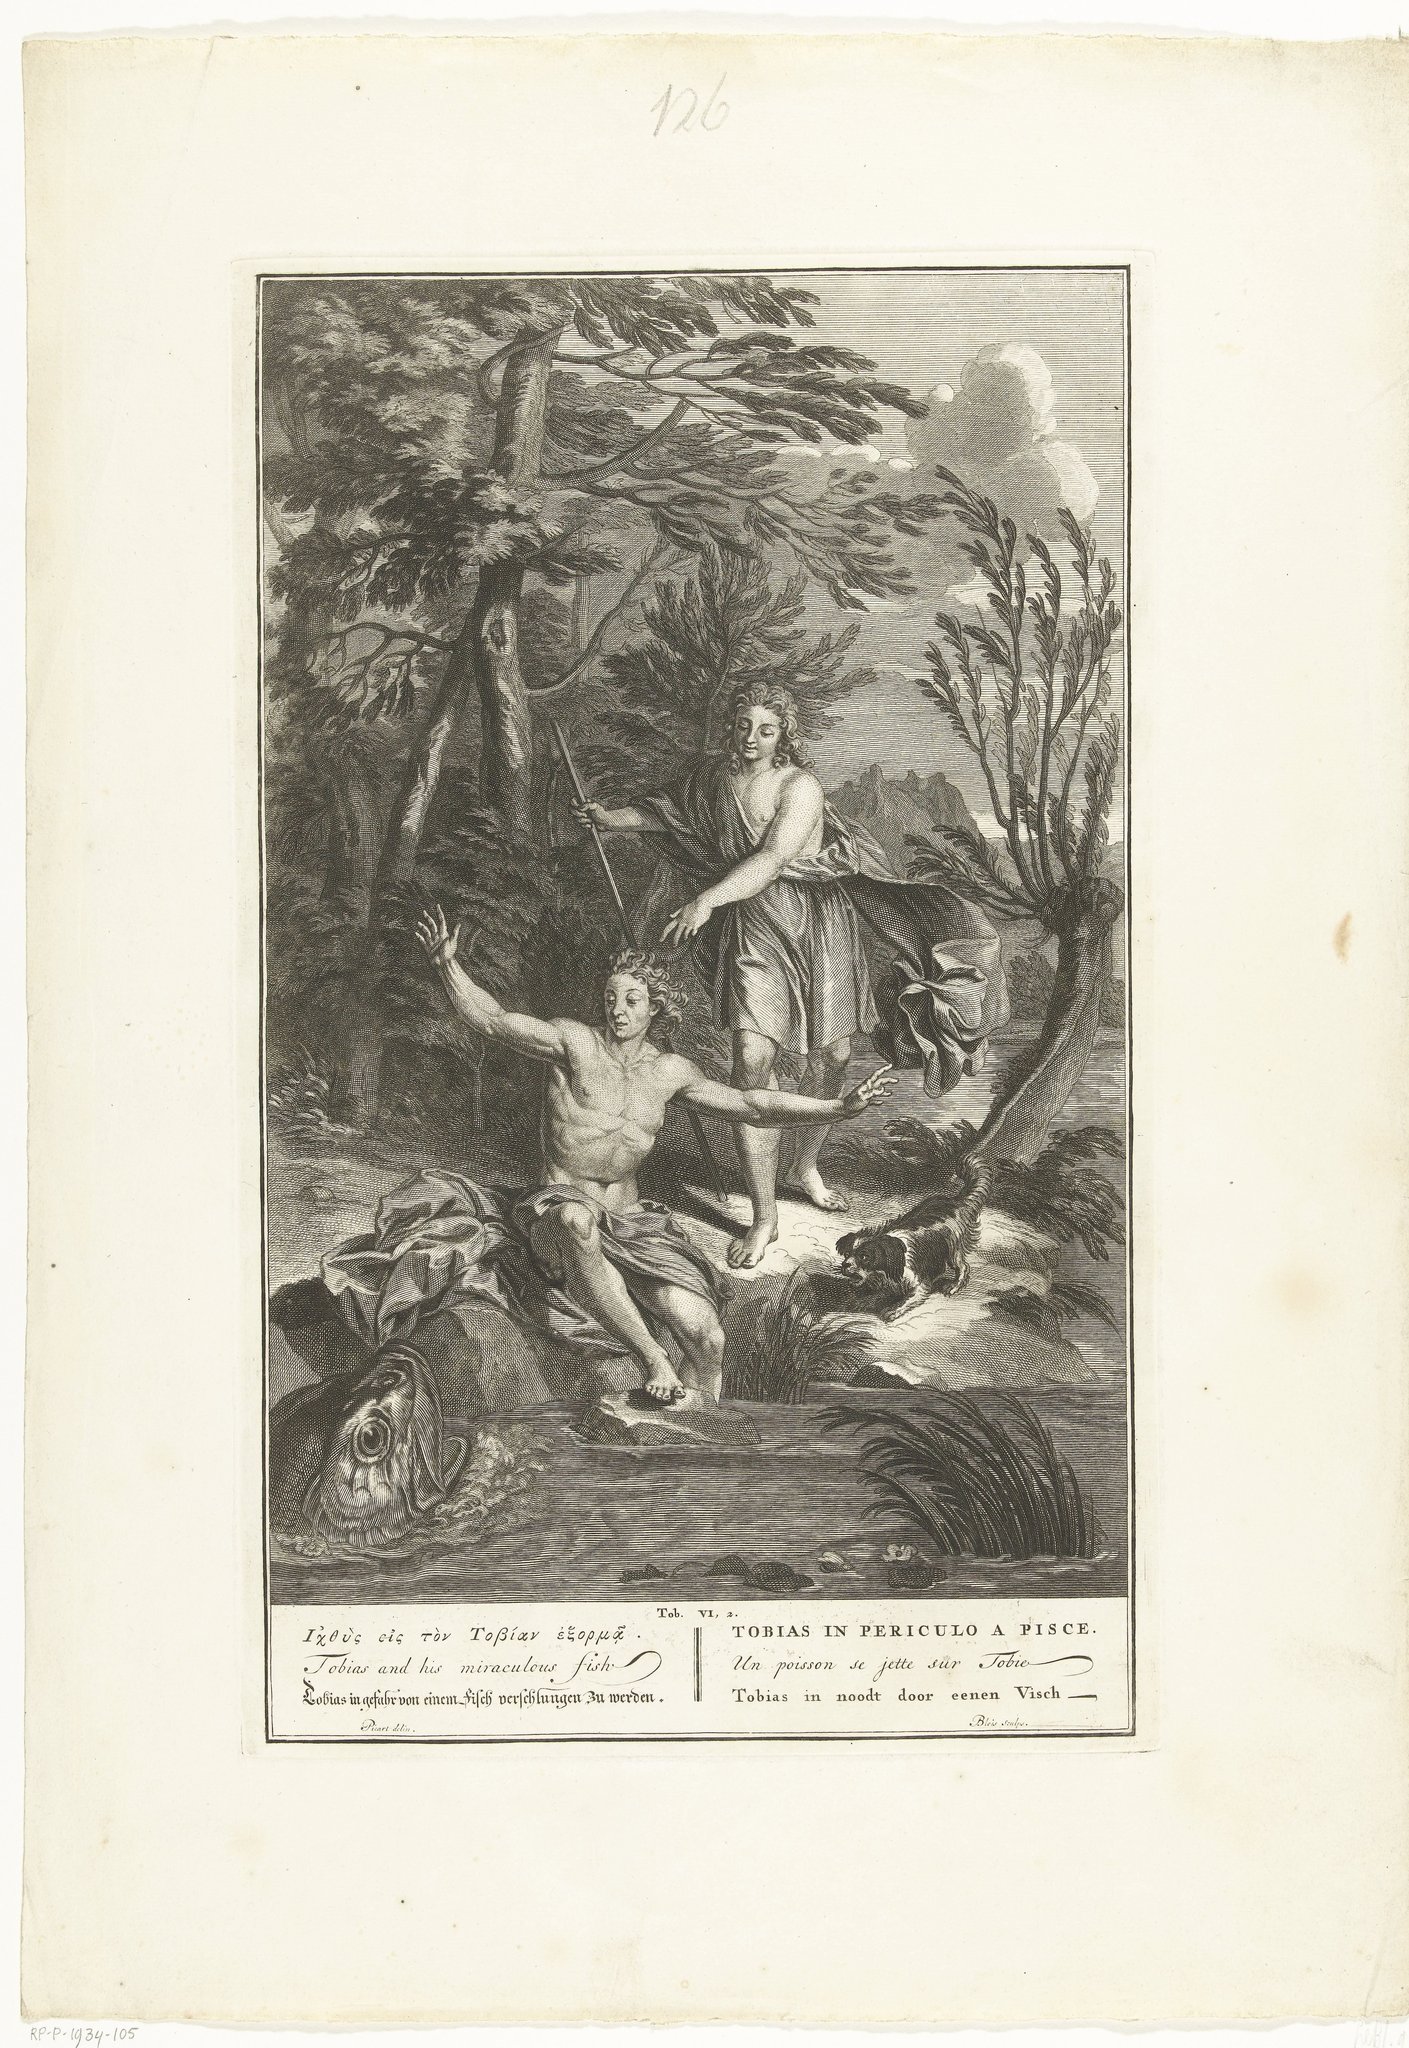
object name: print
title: Tobias en de vis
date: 1679-1717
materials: paper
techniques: engraving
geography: amsterdam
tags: a large fish appears while tobias is washing his feet; he is frightened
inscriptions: collector's mark: Lugt 2228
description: Prent voor: Hoet, Gerard, Taferelen der voornaamste geschiedenissen van het Oude en Nieuwe Testament, en andere boeken, bij de Heilige Schrift gevoegt, door Hoet, Houbraken, en Picart getekent en van de beste meesters in koper gesneden en met beschrijvingen uitgebreid, 3 delen, 's-Gravenhage, Pieter de Hondt, 1728